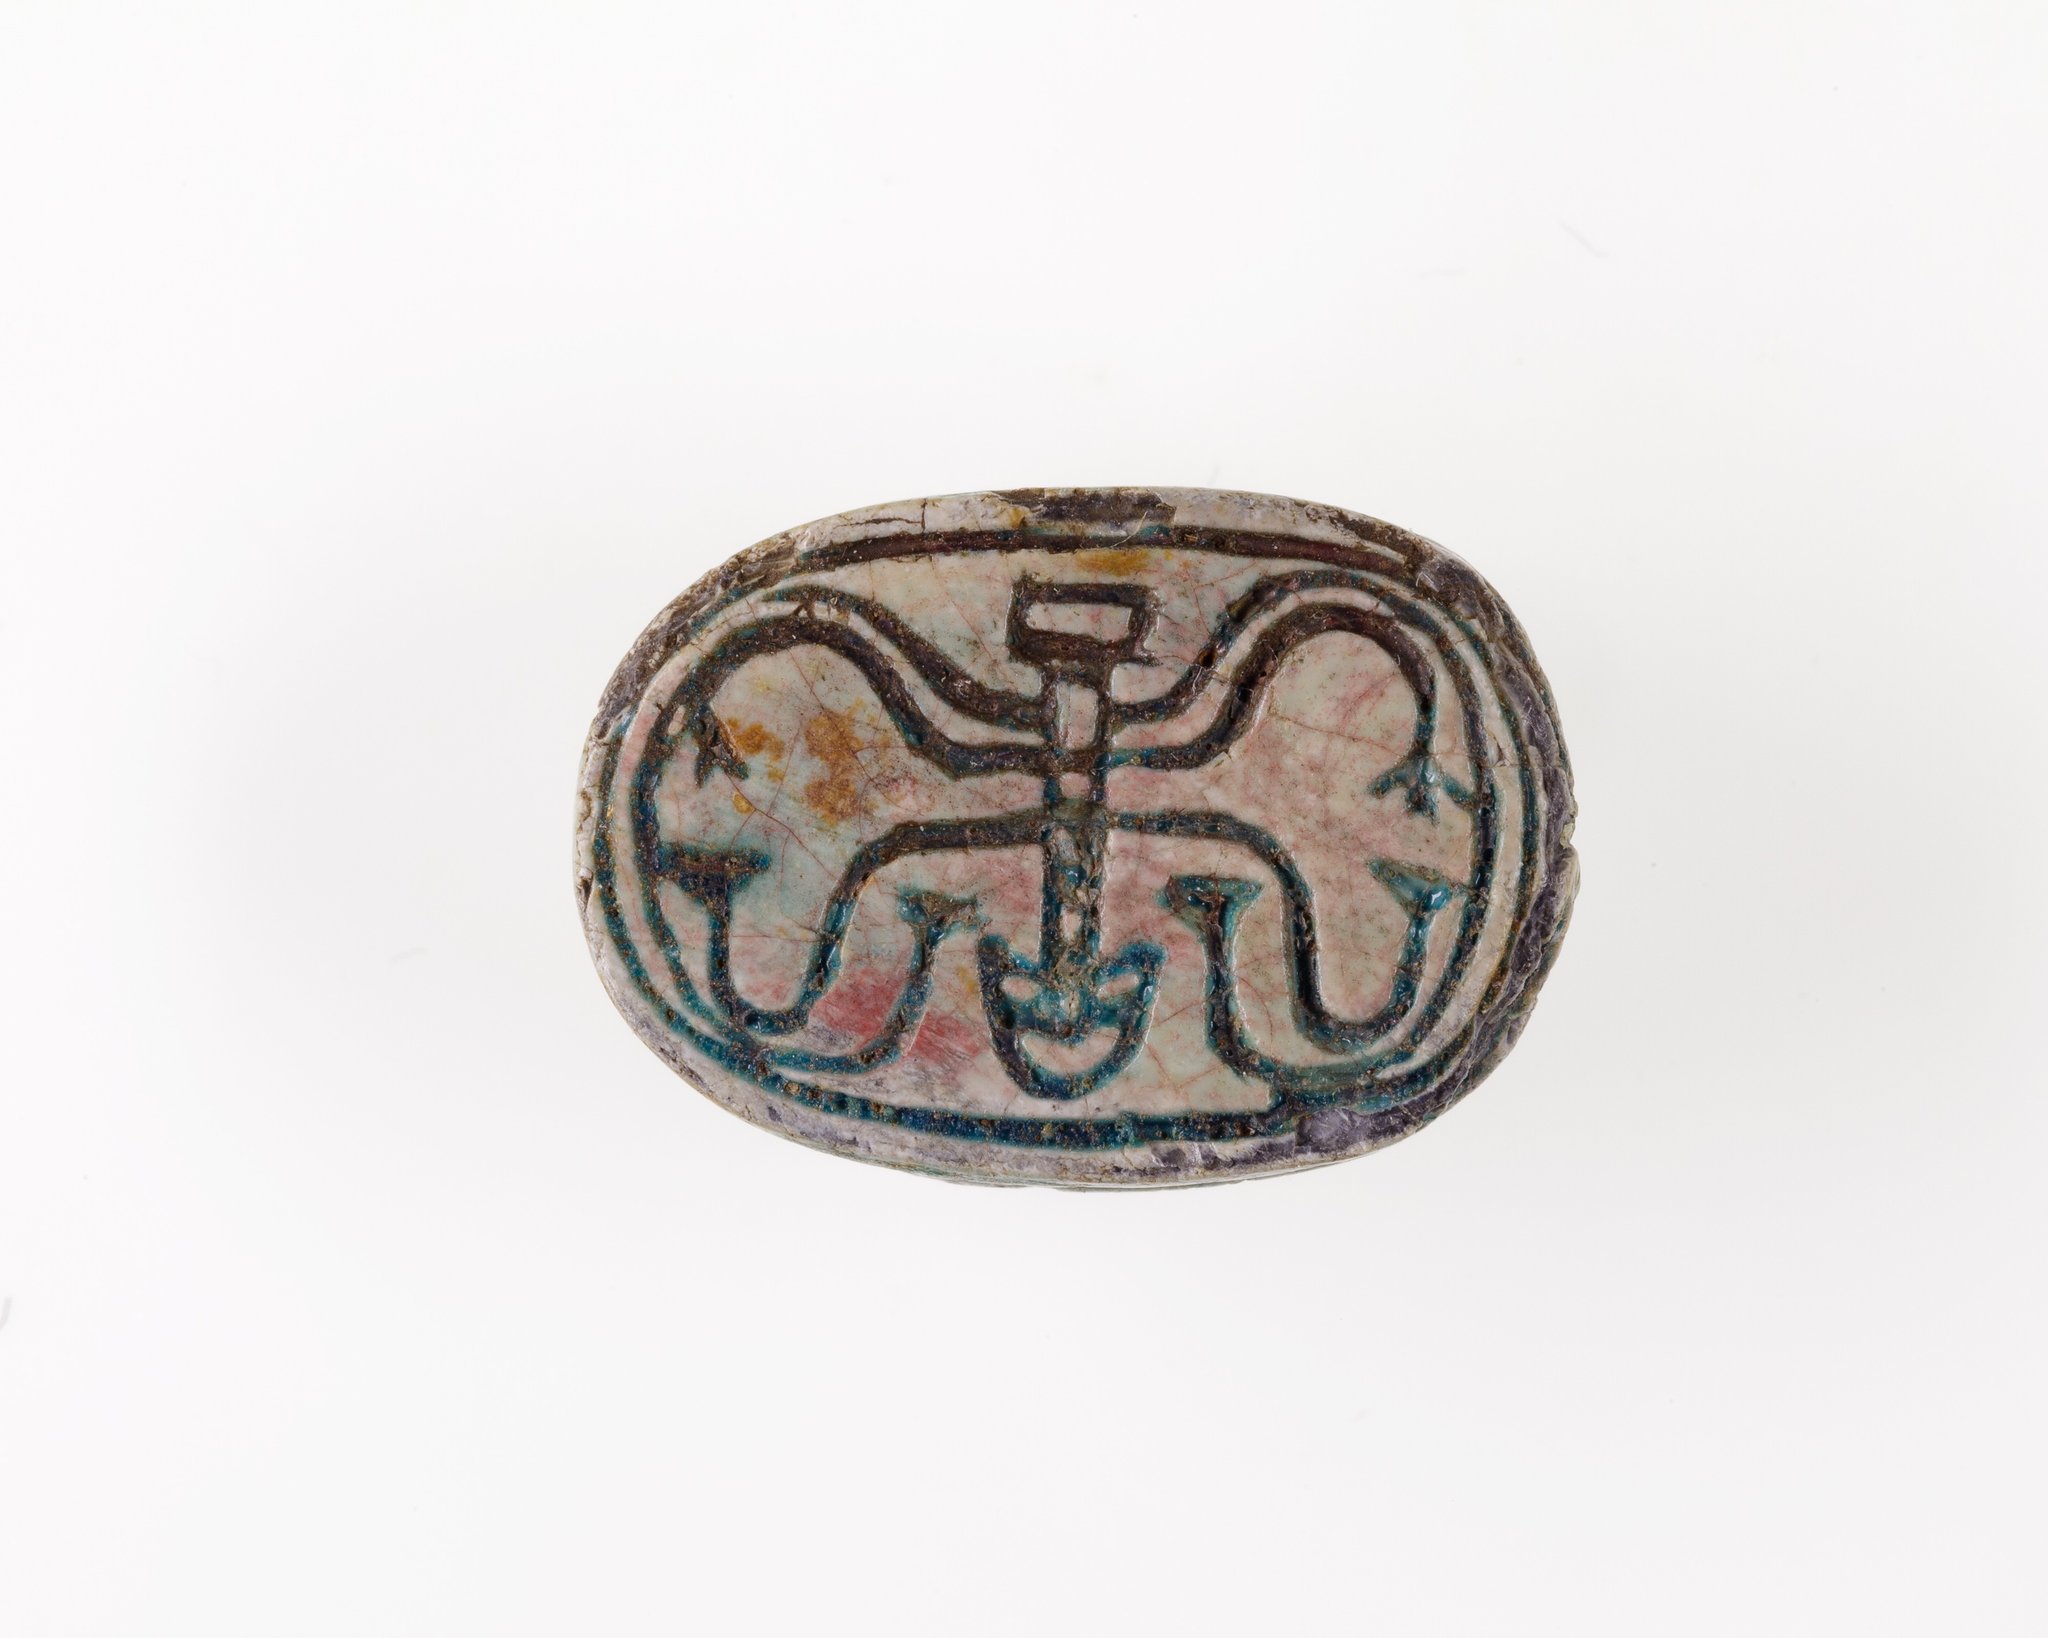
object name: scarab, sema tawy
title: Scarab Decorated with Symbol of Unification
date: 1981-1295 BCE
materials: glaze, stone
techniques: glazing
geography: egypt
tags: scarabs